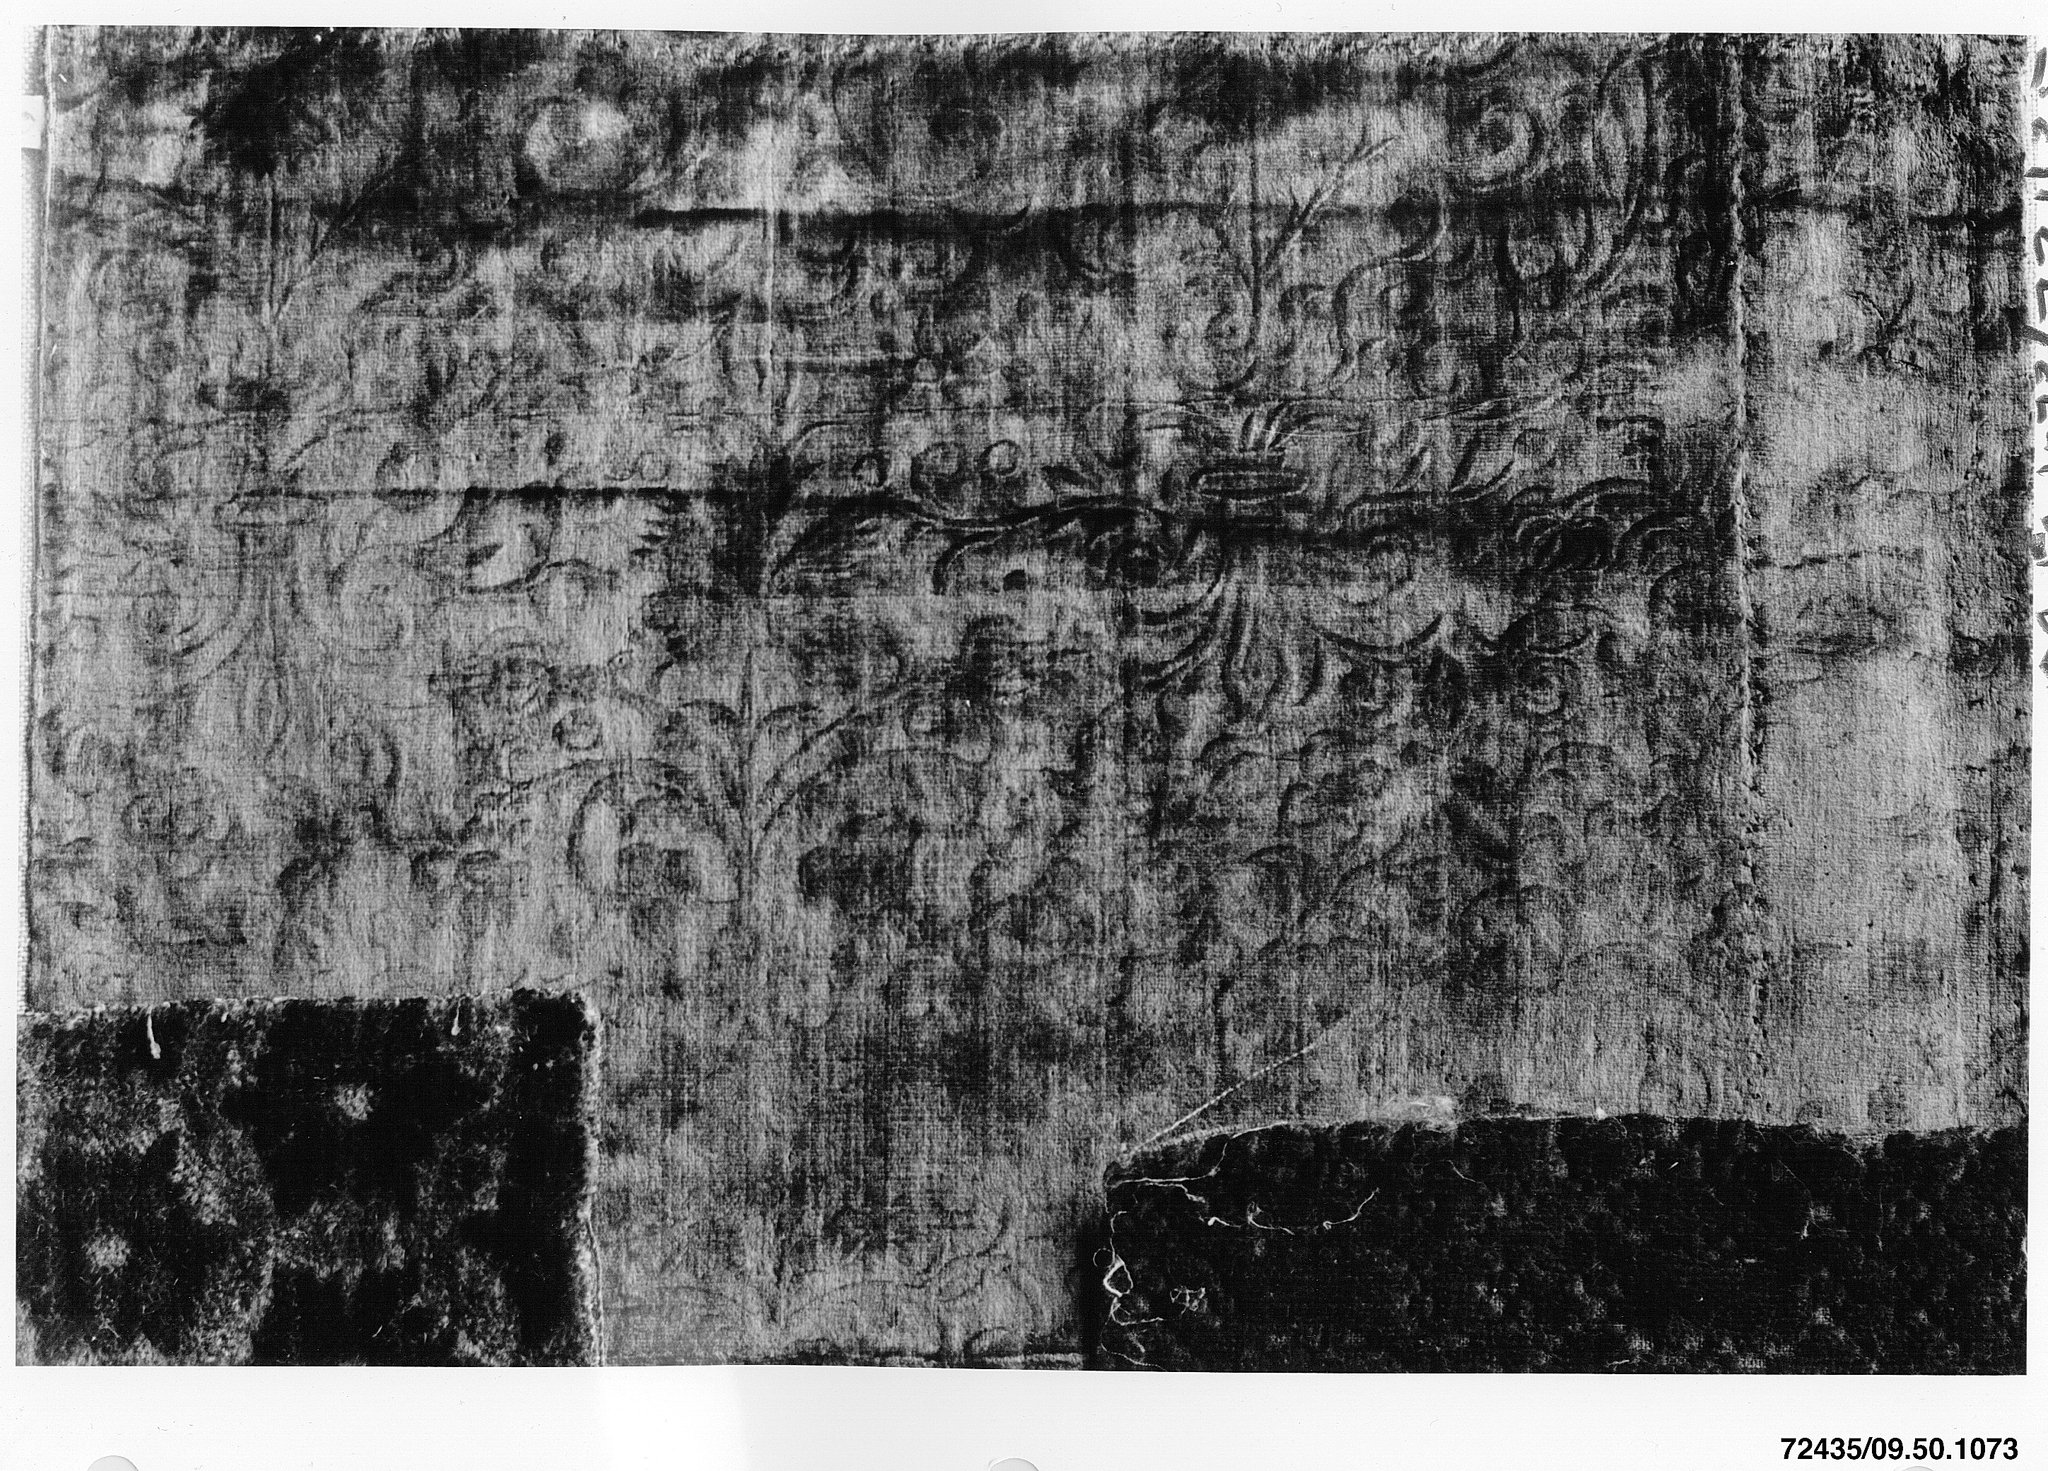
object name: piece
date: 1567-1600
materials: silk